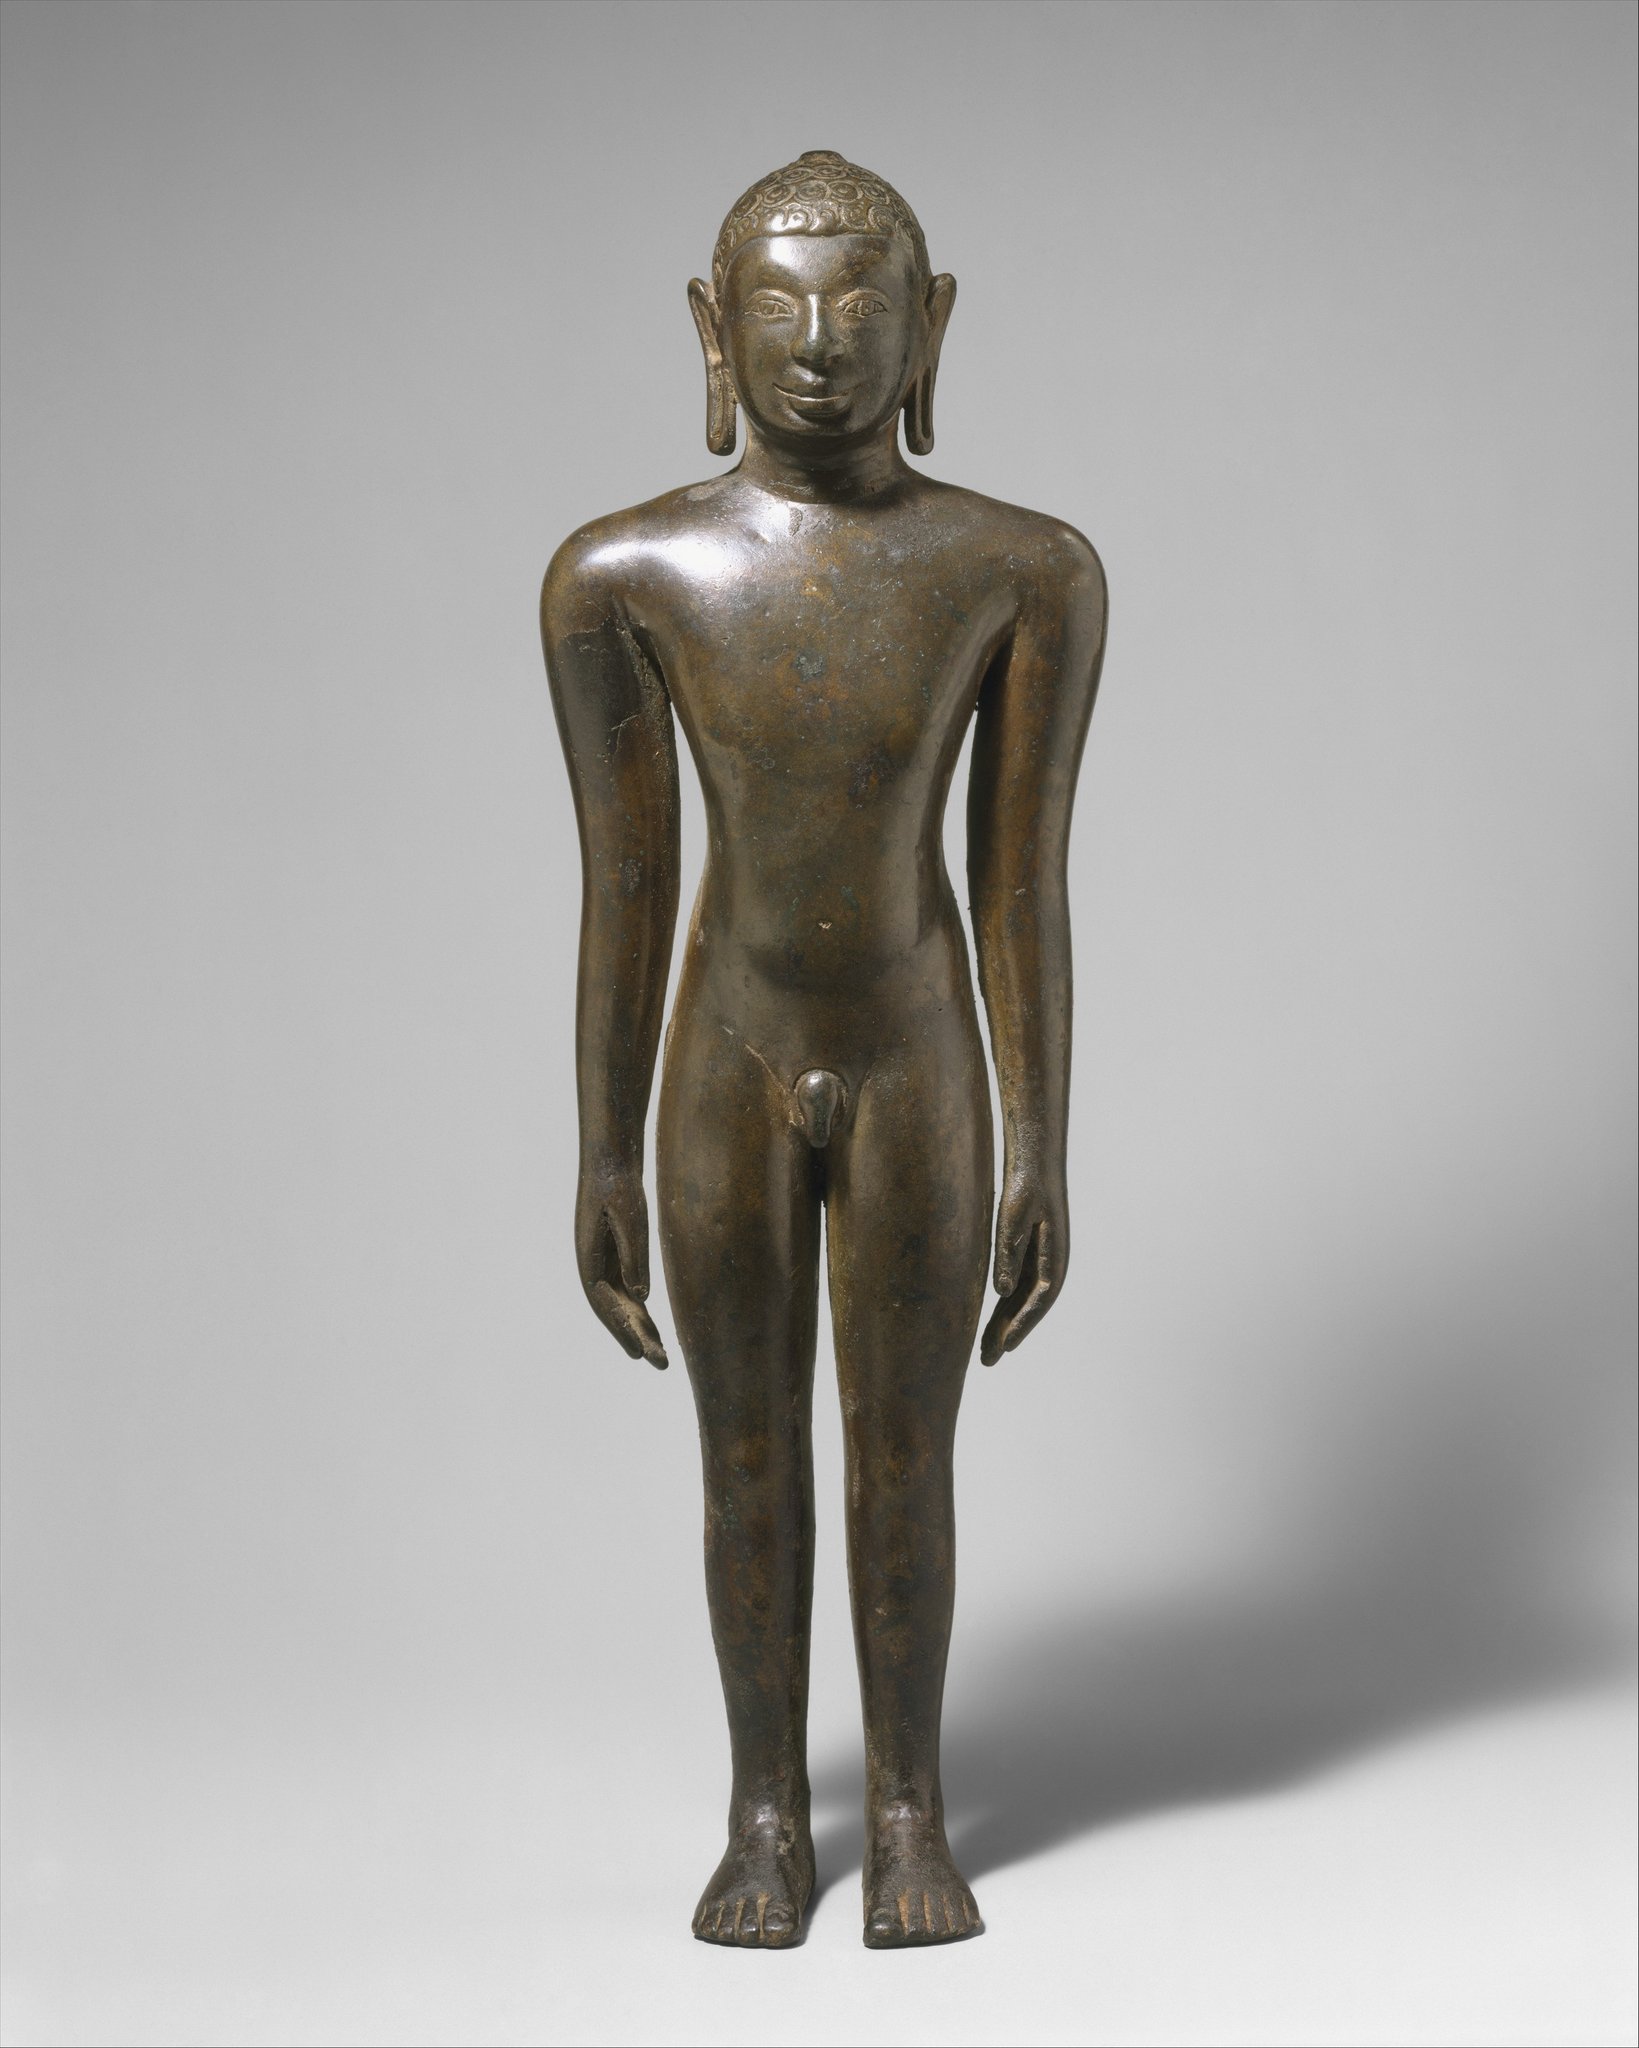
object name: figure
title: Jain Digambara Tirthanhara Standing in Kayotsarga Meditation Posture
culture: indian, karnataka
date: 801-900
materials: copper alloy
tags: male nudes